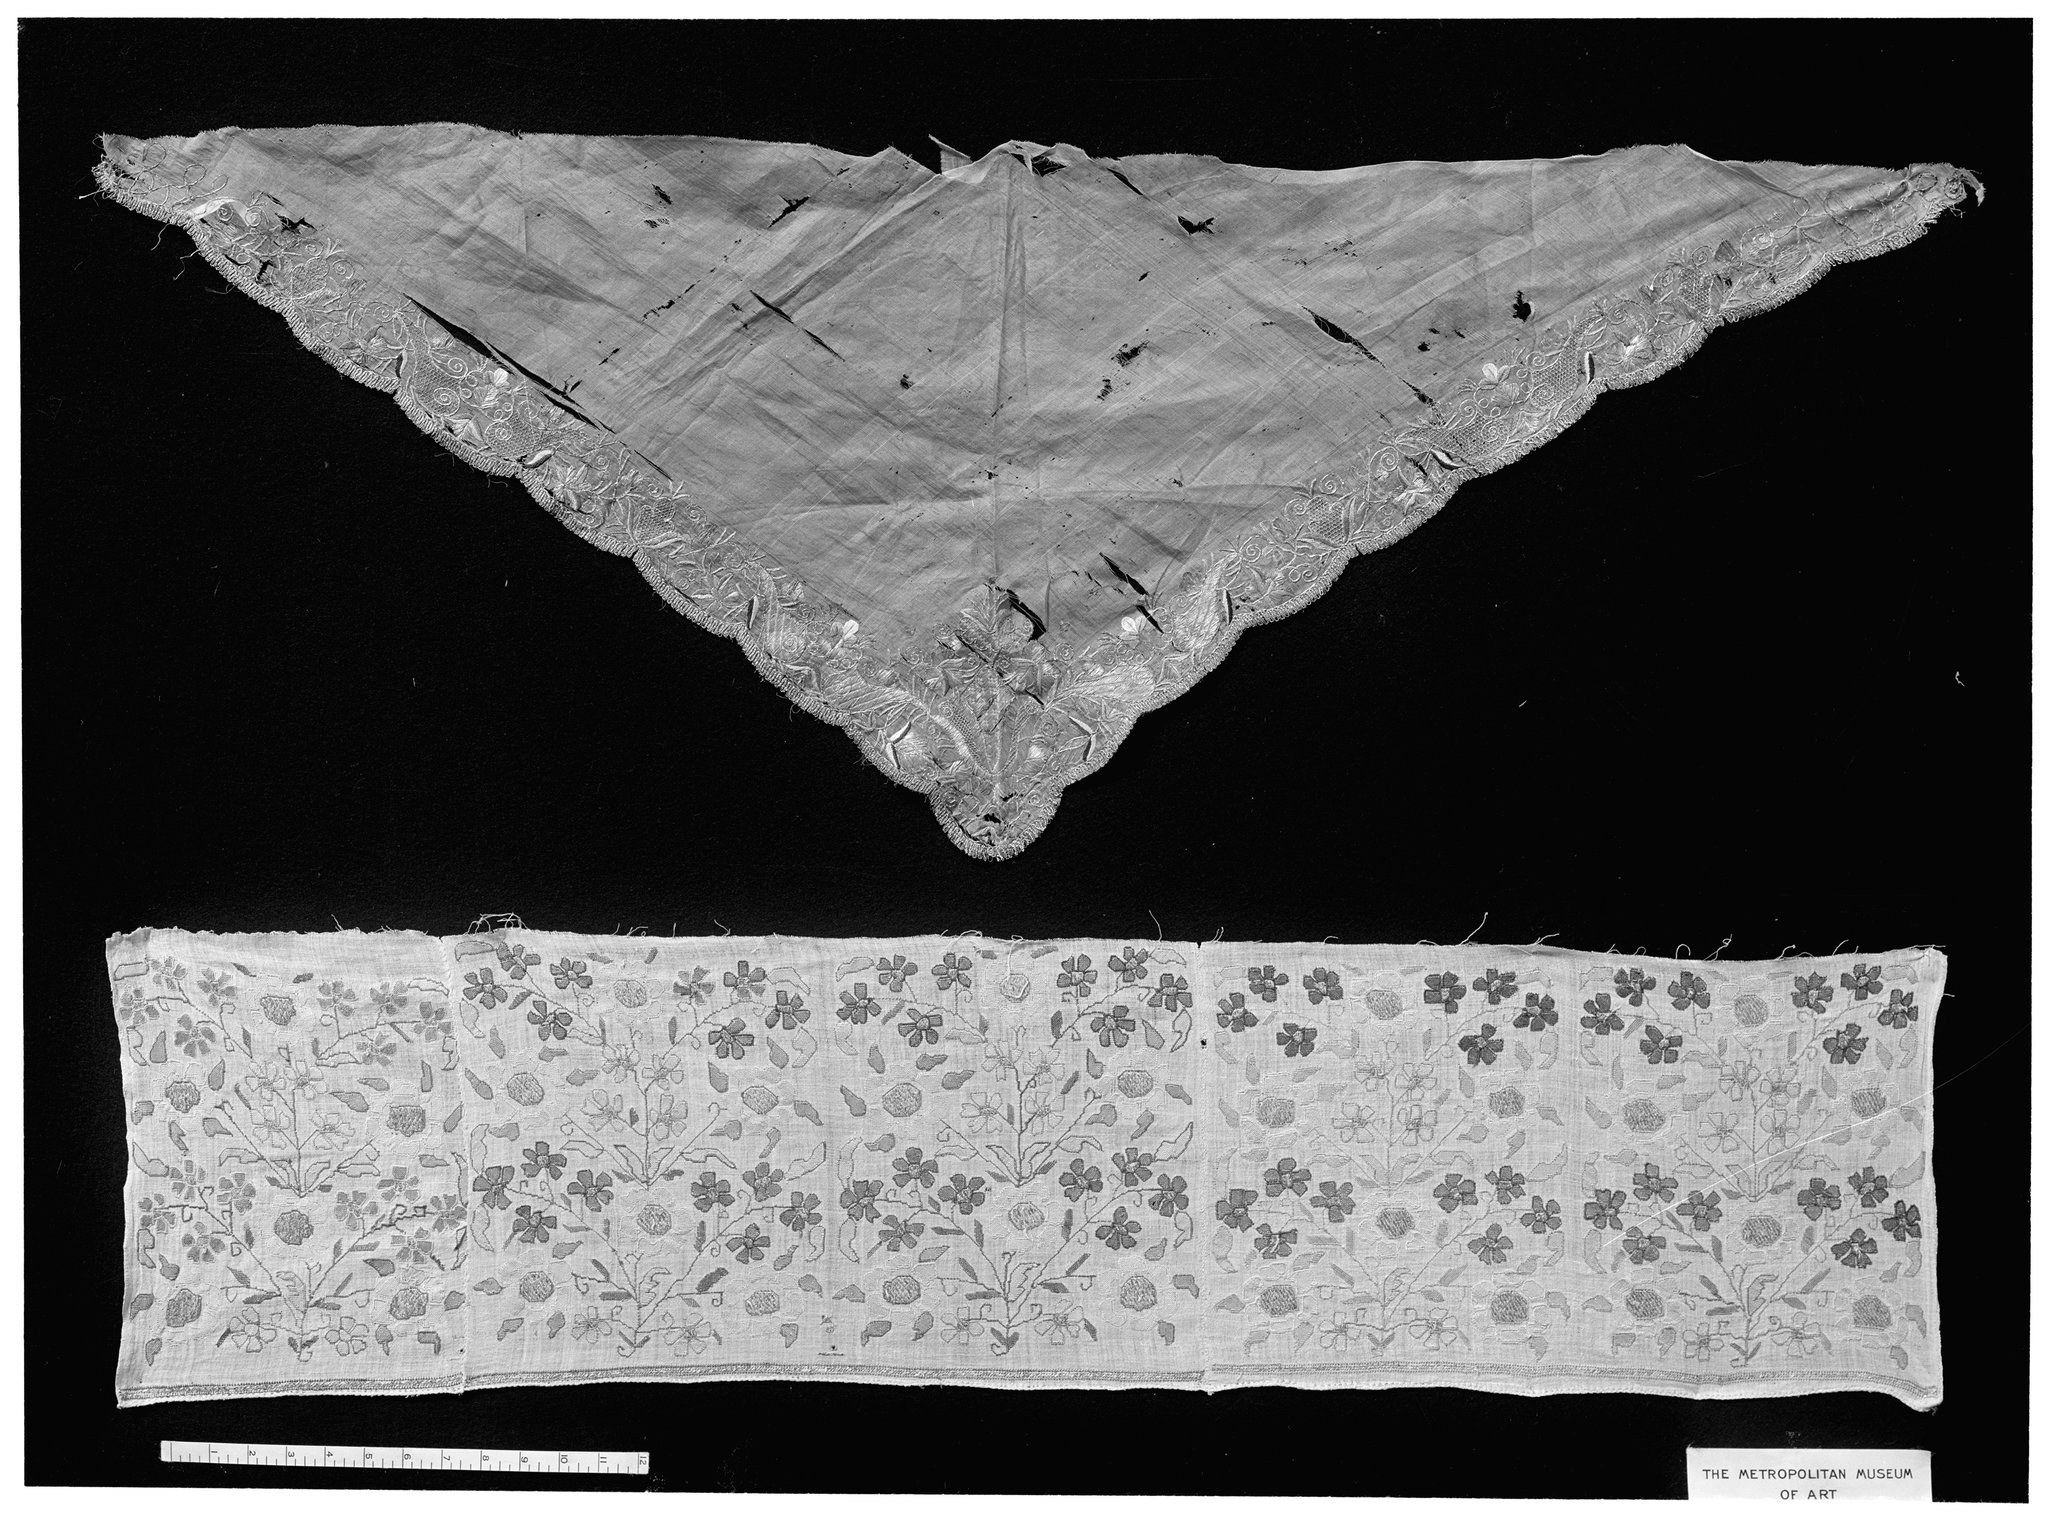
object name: textile fragment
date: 1801-1833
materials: metal thread, silk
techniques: embroidery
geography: turkey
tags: flowers